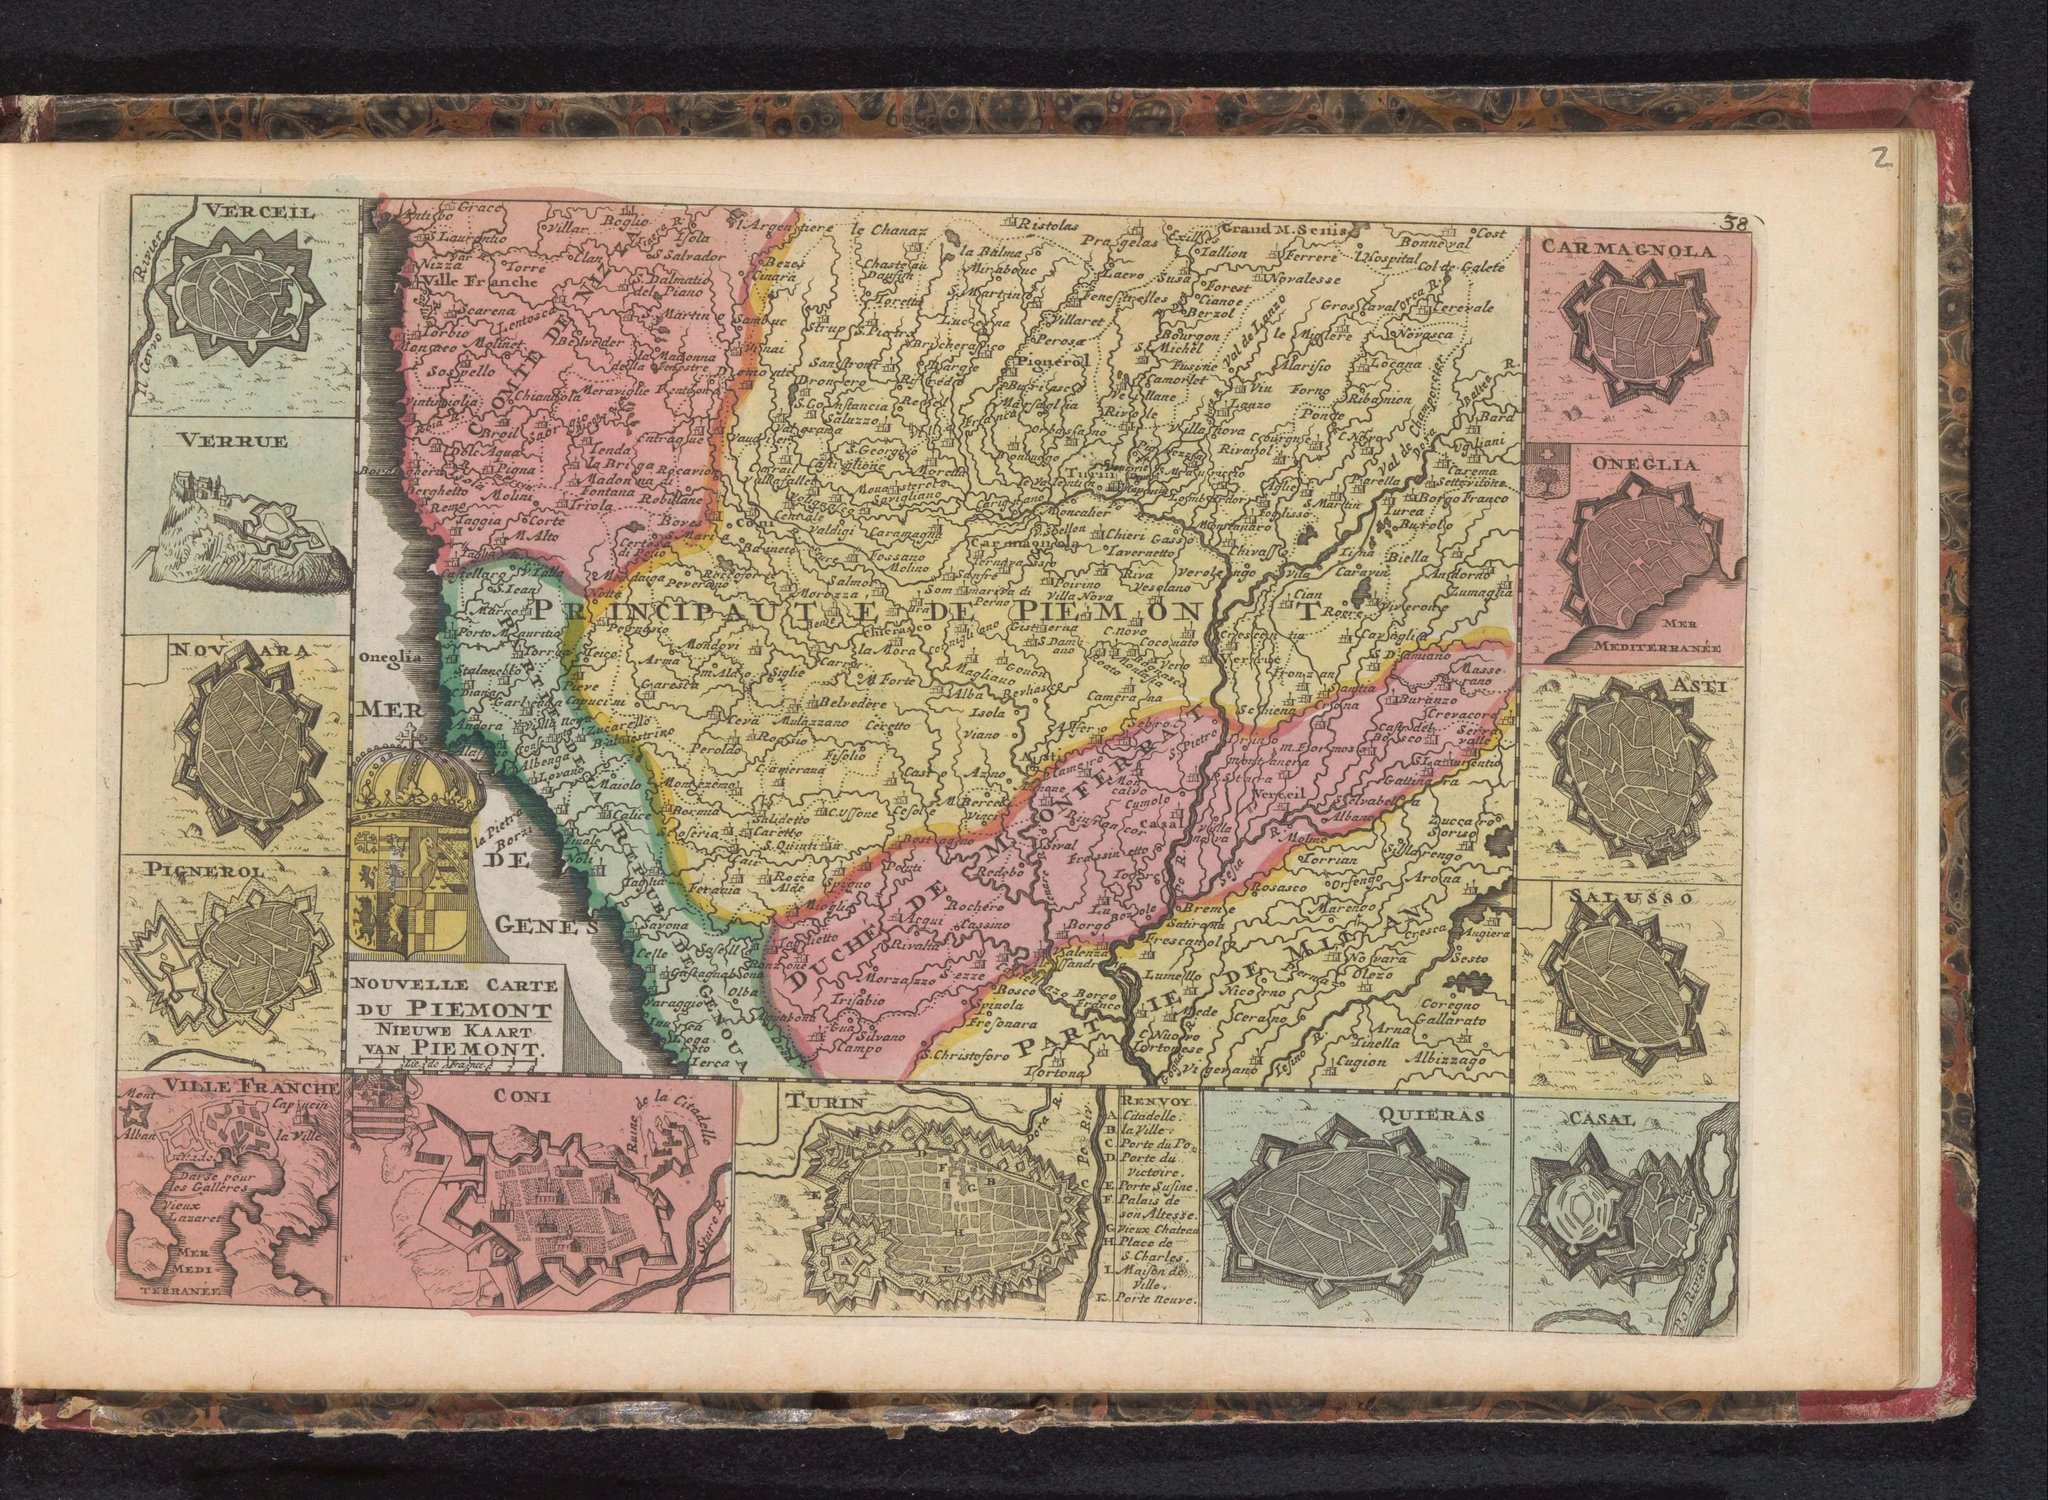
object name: print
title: Nouvelle Carte du Piemont / Nieuwe Kaart van Piemont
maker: Anonymous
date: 1700-1706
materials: paper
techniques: engraving, etching, hand coloring, lacquer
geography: northern netherlands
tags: maps of separate countries or regions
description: Kaart van de Italiaanse streek Piemonte. Om de kaart dertien kleinere plattegronden van steden. Onderdeel van een atlas met 223 kaarten van landen en steden en oorlogstaferelen in Europa in de periode ca. 1690-1735.